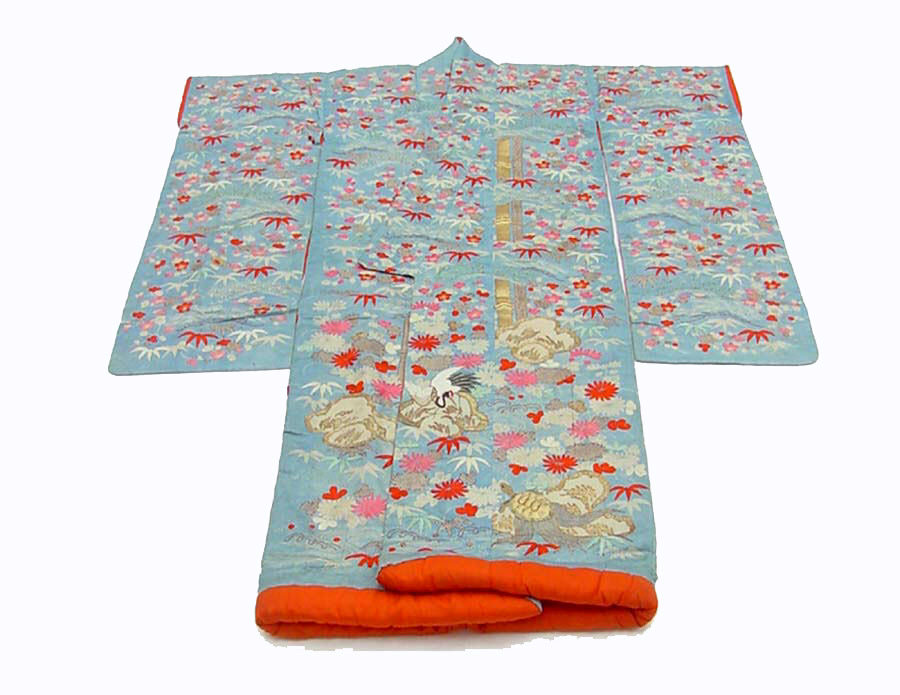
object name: kosode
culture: japanese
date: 1867-1933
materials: metal thread, silk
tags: birds,flowers